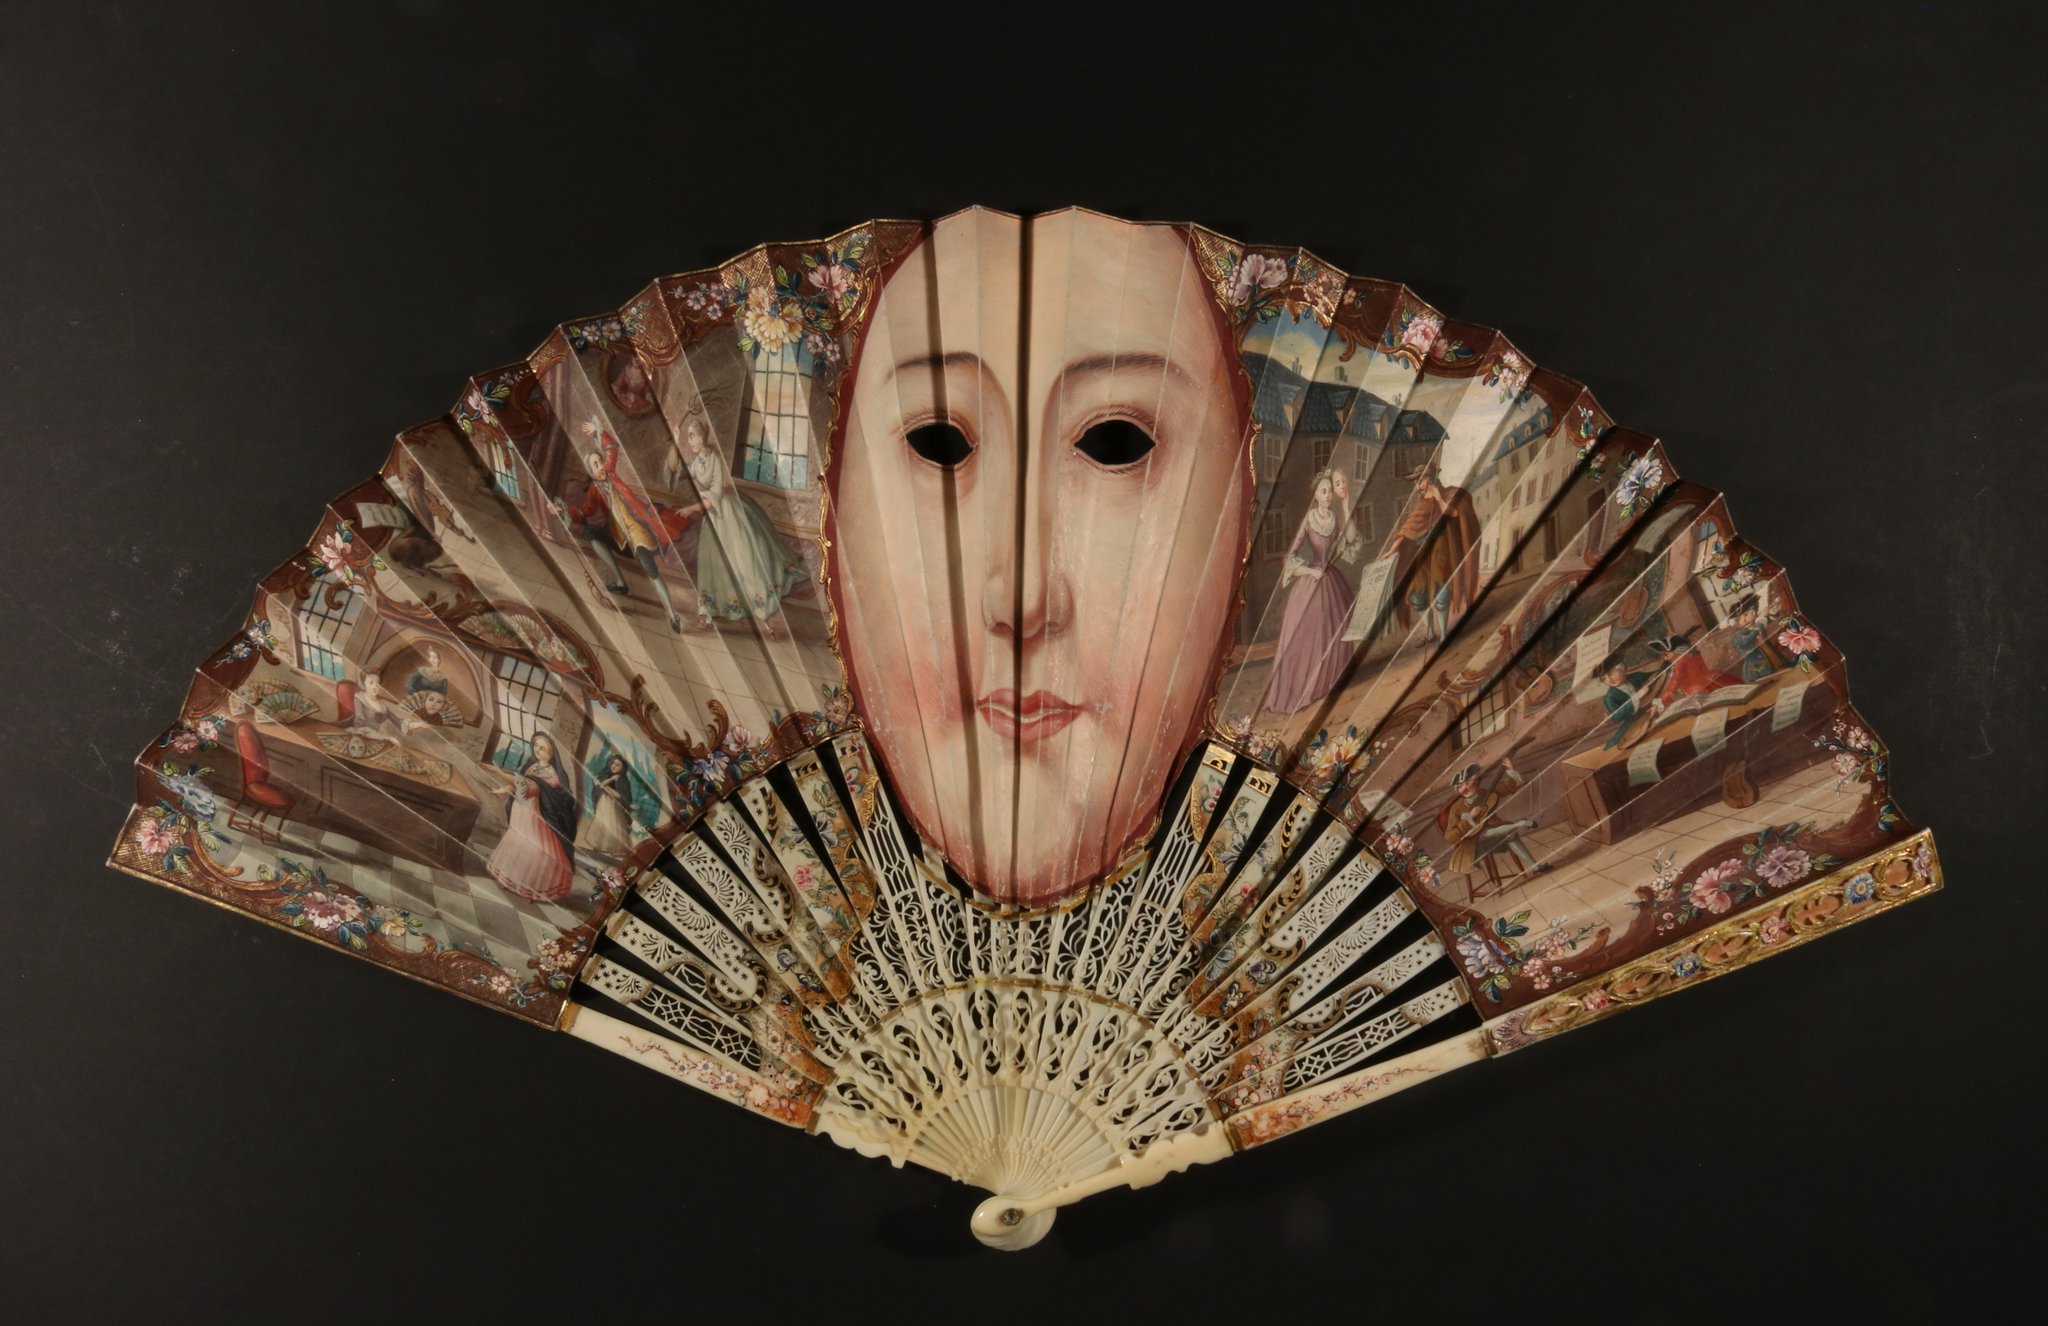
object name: fan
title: Folding Fan Depicting a Mask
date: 1745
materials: gouache, ivory, parchment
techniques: painting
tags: musical instruments,masks,men,women